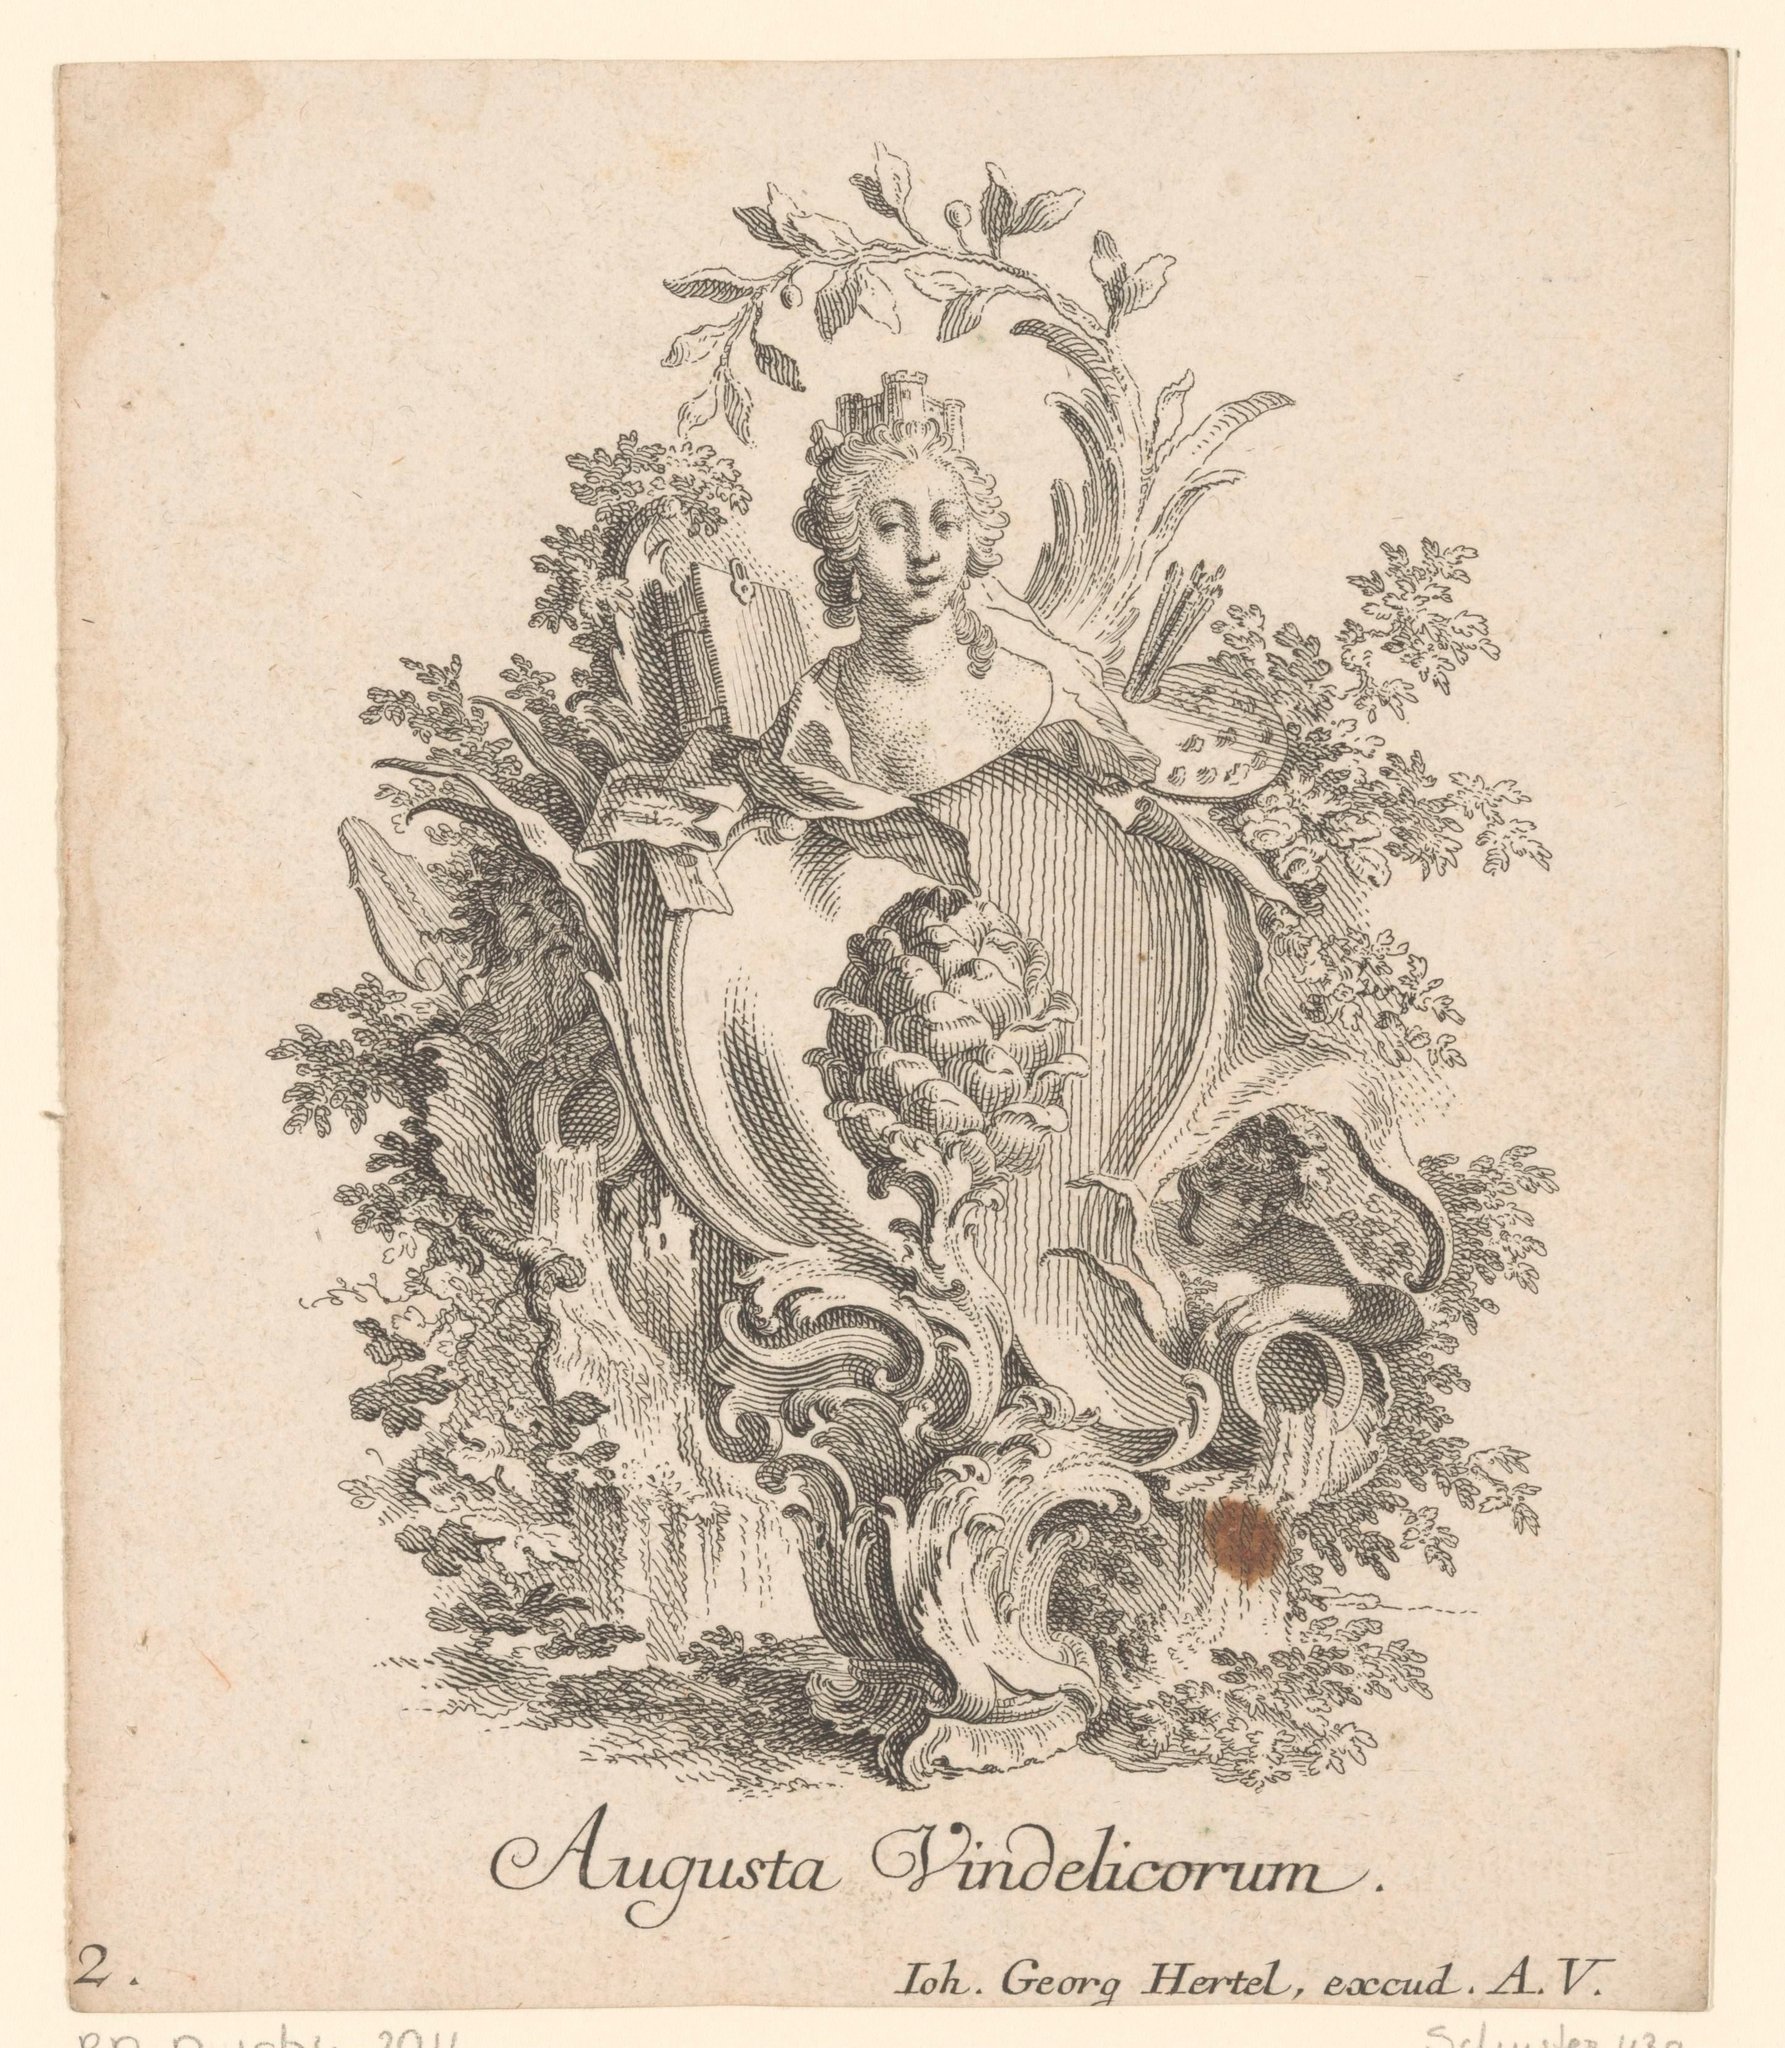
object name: print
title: Augusta Vindelicorum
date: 1731-1775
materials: paper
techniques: engraving, etching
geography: augsburg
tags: personification of a city, town-patron(ess), ornament ~ cartouche, augsburg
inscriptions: collector's mark: Lugt 2228, collector's mark: Lugt 2760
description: Cartouche met een personificatie van de stad Augsburg met attributen van kunsten en wetenschappen, personificaties van rivieren en het symbool van de stad: een dennenappel. Uitgeversnummer 52.